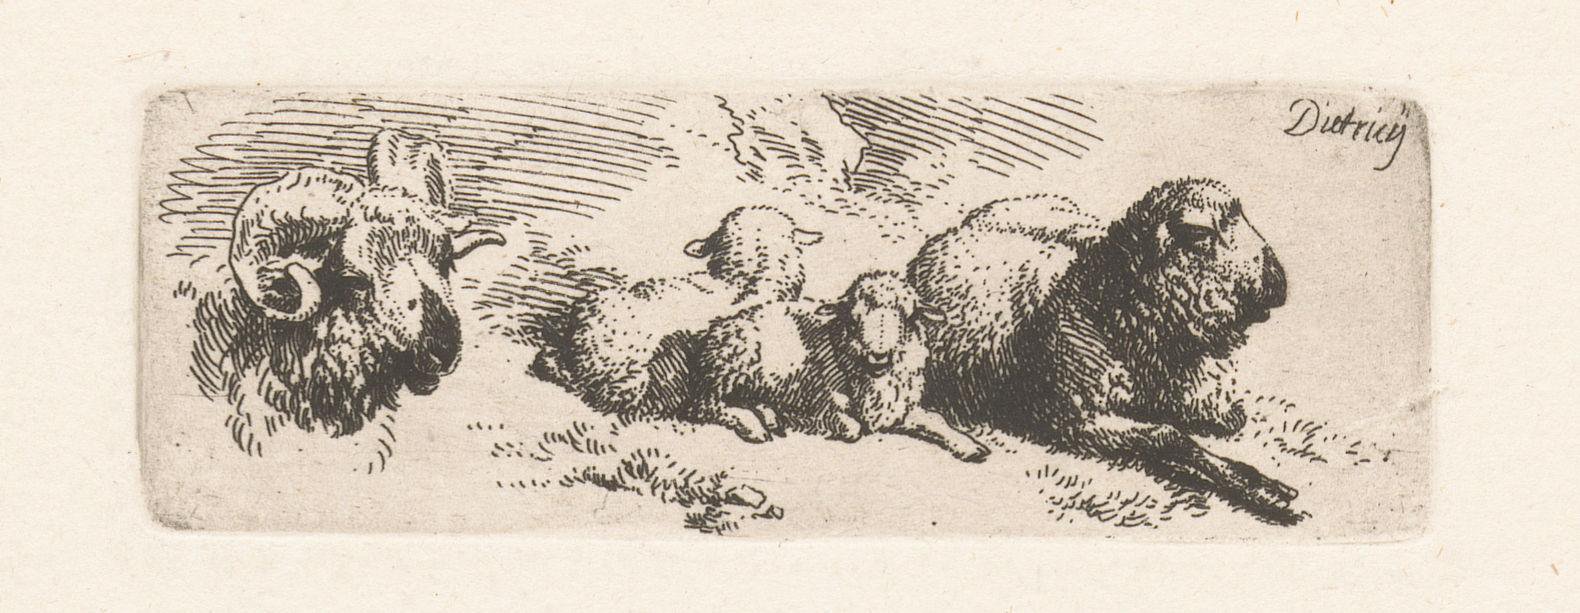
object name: print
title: Ram, schaap en lammeren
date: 1722-1774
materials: paper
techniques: etching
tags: ram, lamb, sheep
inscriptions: collector's mark: Lugt 240